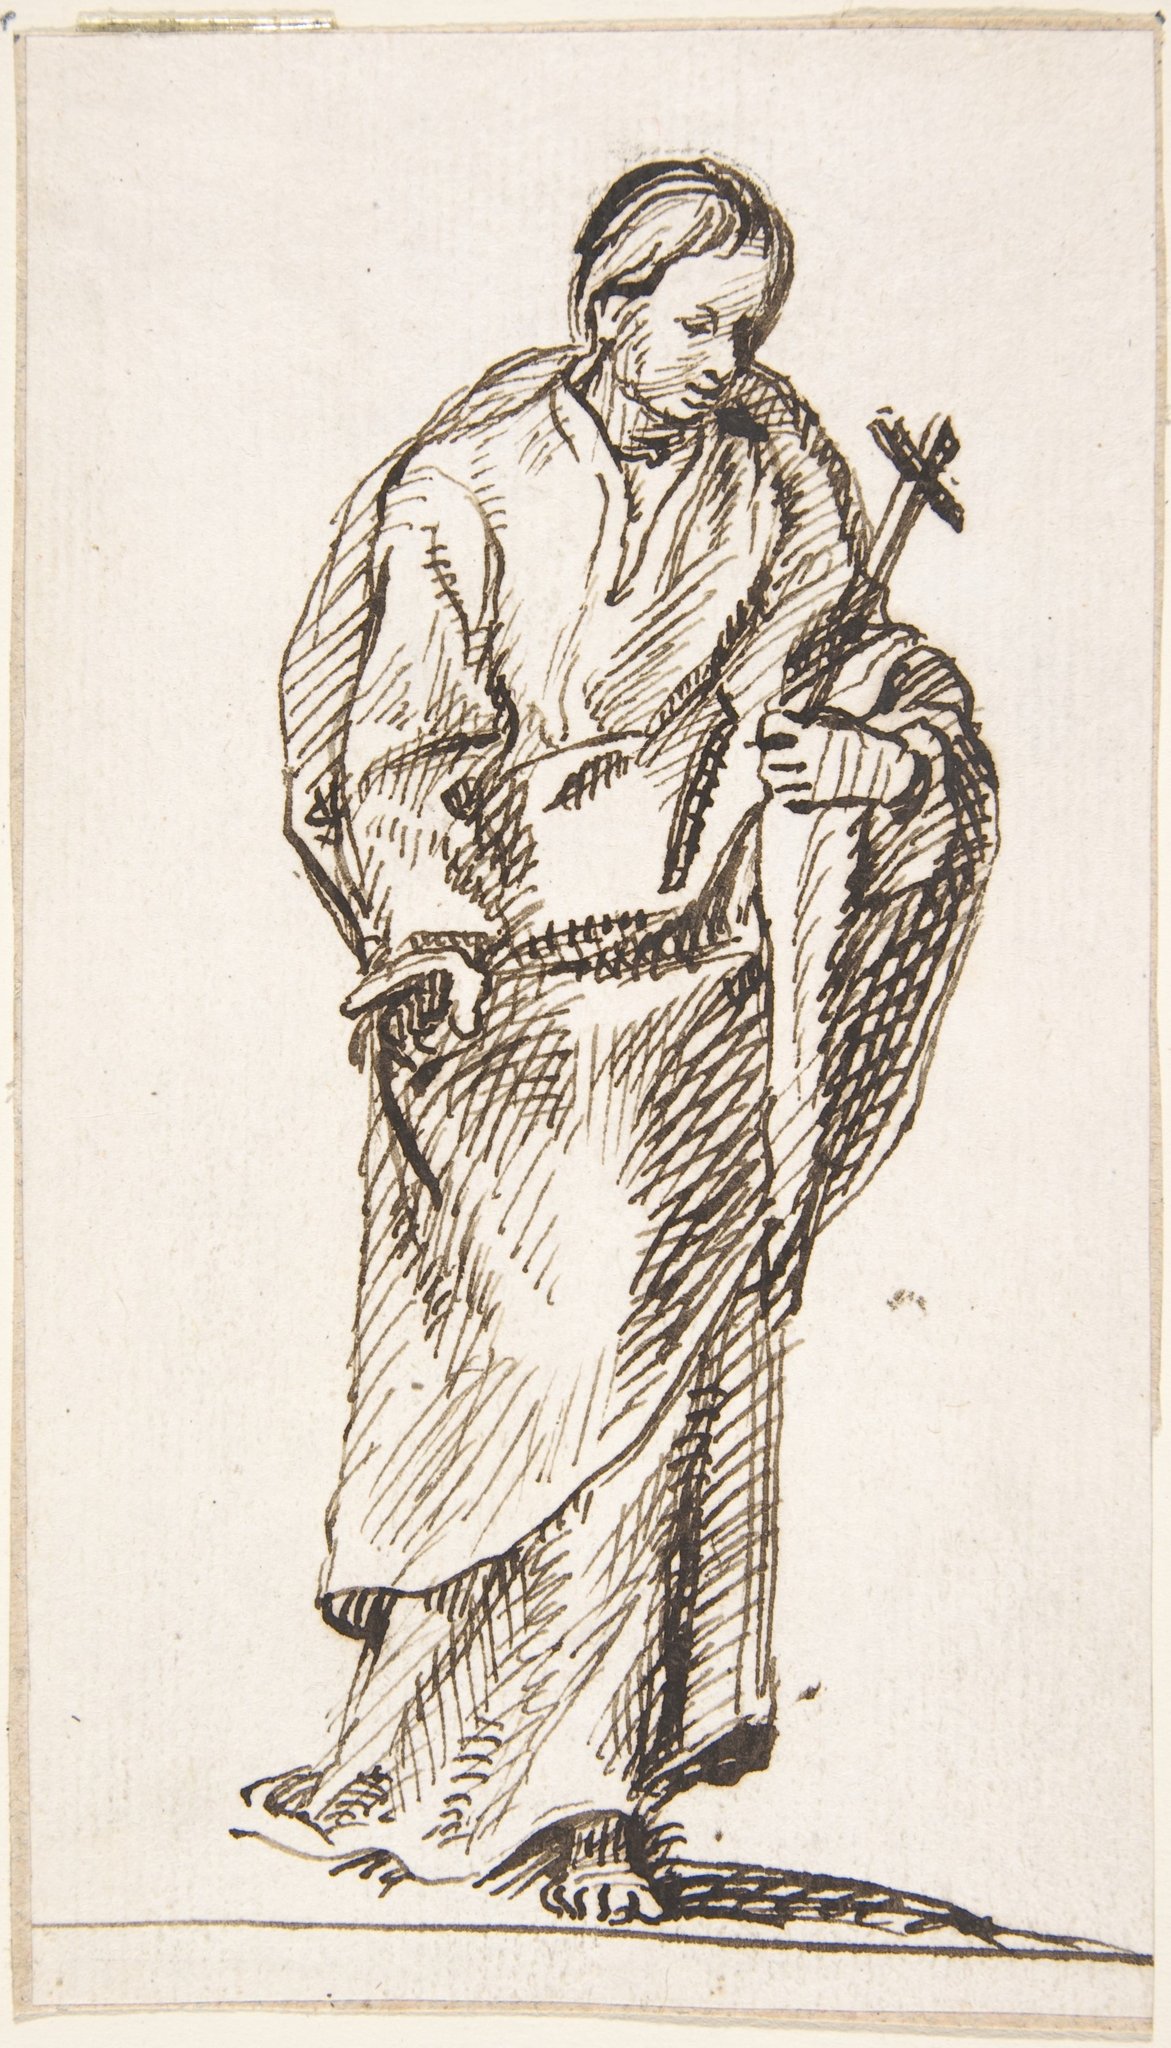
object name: drawing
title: Standing Figure Holding Cross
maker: pedro duque cornejo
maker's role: artist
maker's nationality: spanish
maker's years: 1677-1757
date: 1700-1750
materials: chalk, ink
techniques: pen, drawing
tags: men,cross